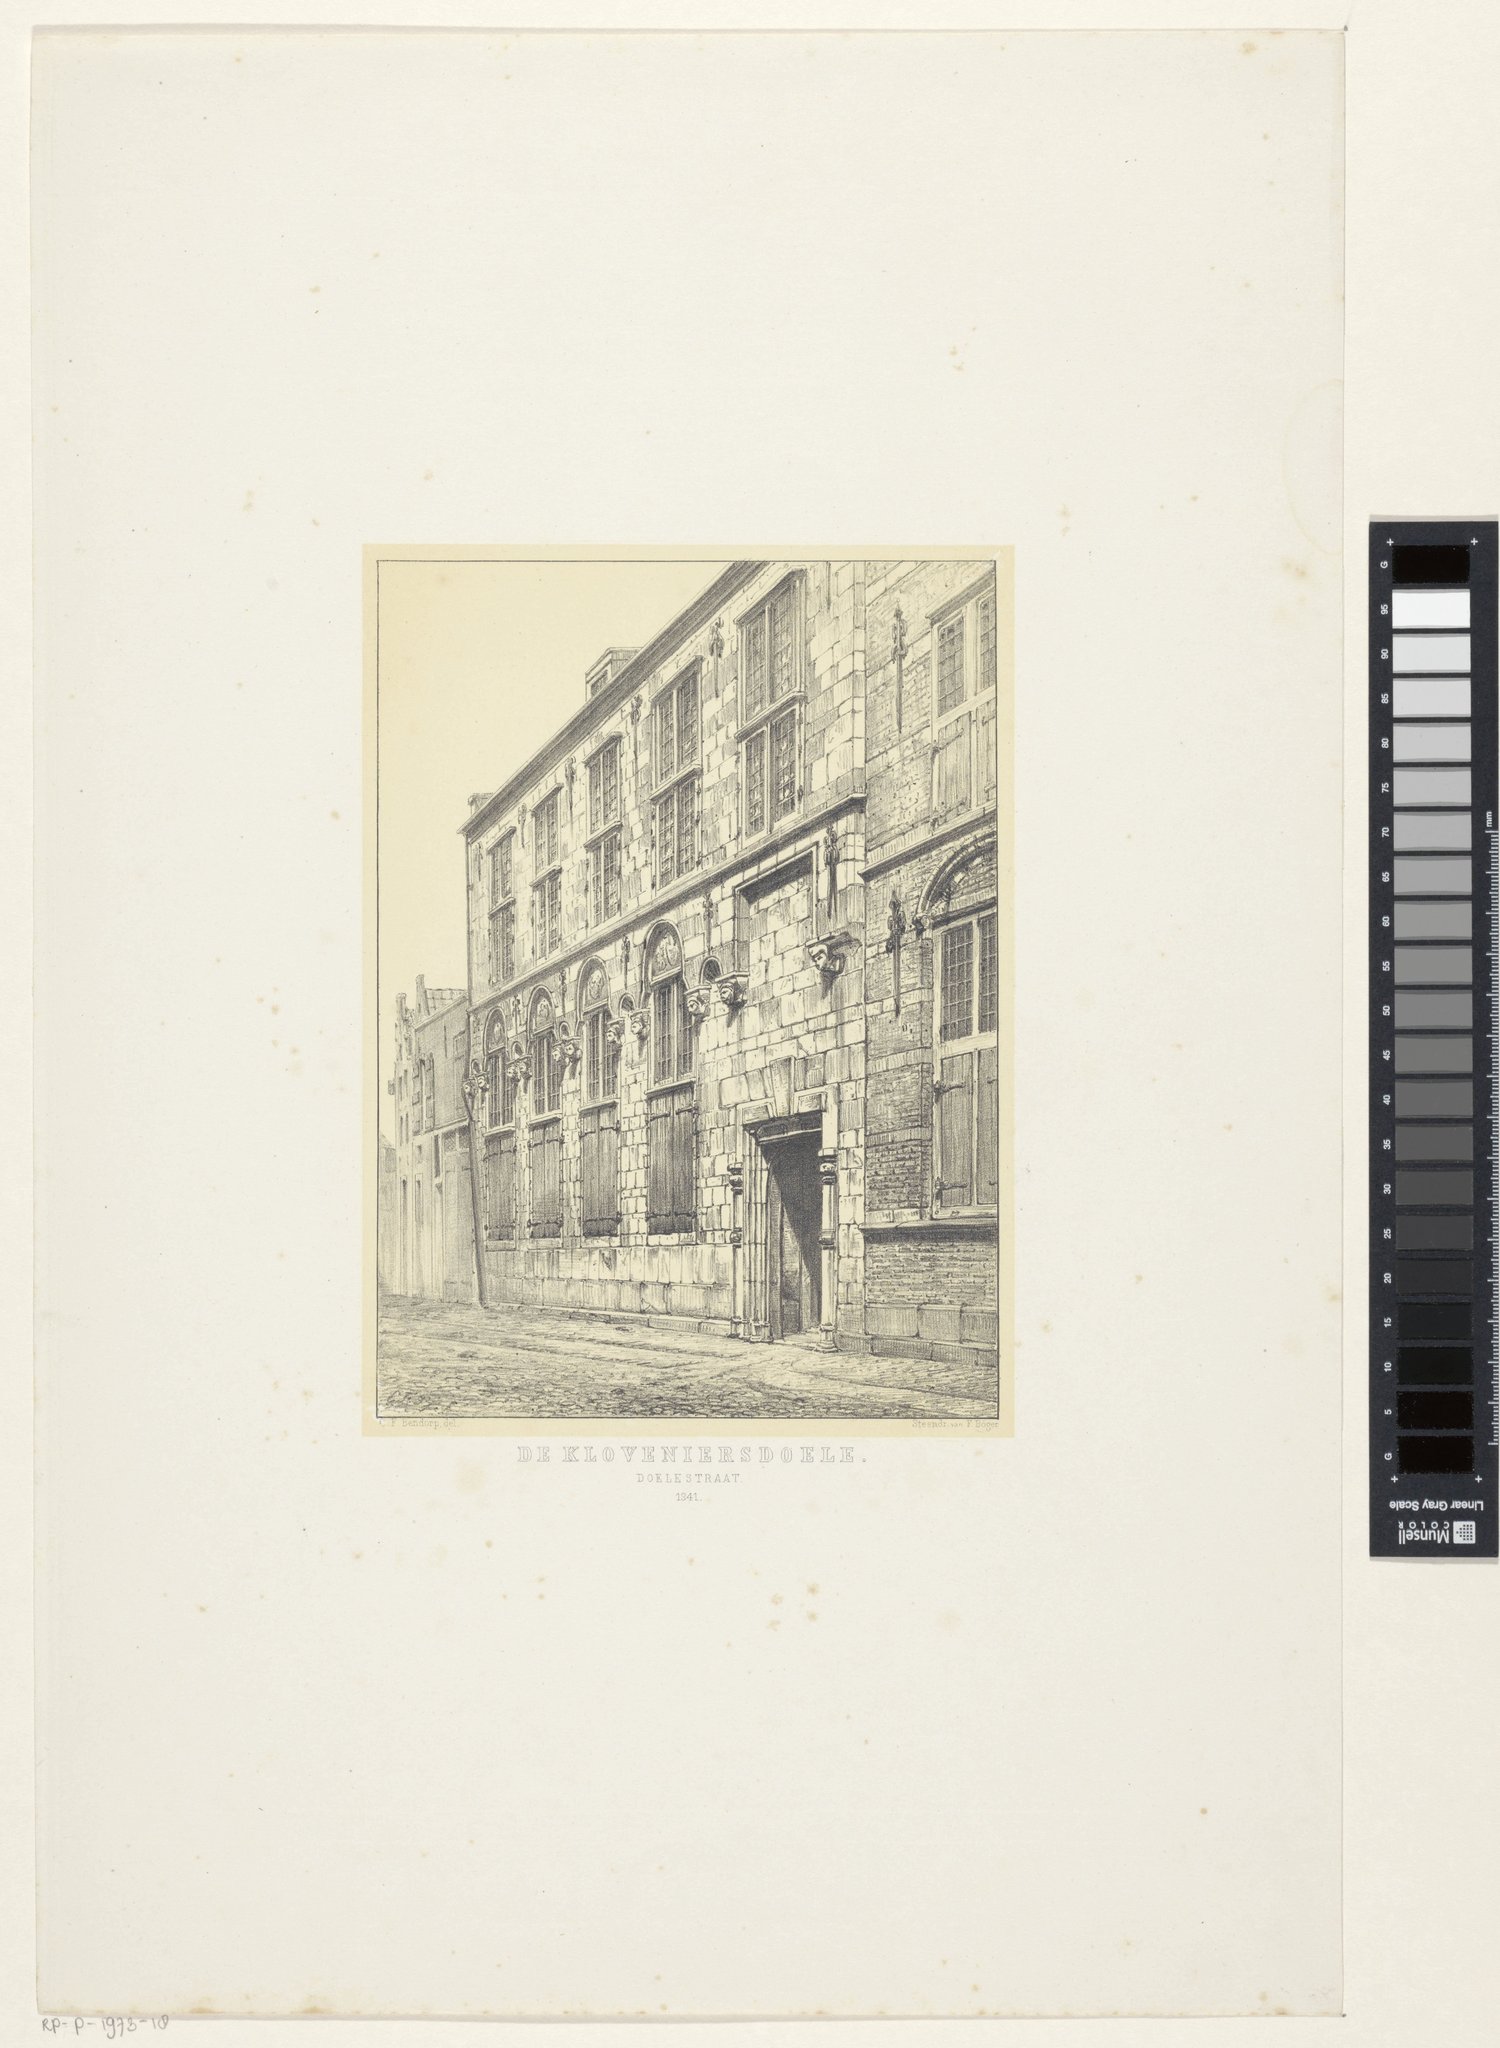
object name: print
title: De Kloveniersdoele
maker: carel frederik bendorp (ii)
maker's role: draughtsman, painter, print maker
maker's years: 1819-1897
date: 1872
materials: paper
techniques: tone lithography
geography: dordrecht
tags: façade (of house or building), dordrecht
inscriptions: collector's mark: Lugt 2228, collector's mark: Lugt 2760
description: De luiken van het gebouw zijn gesloten. Onder de naam van het gebouw staan ook de naam van de straat, Doelestraat, en het jaartal 1841.